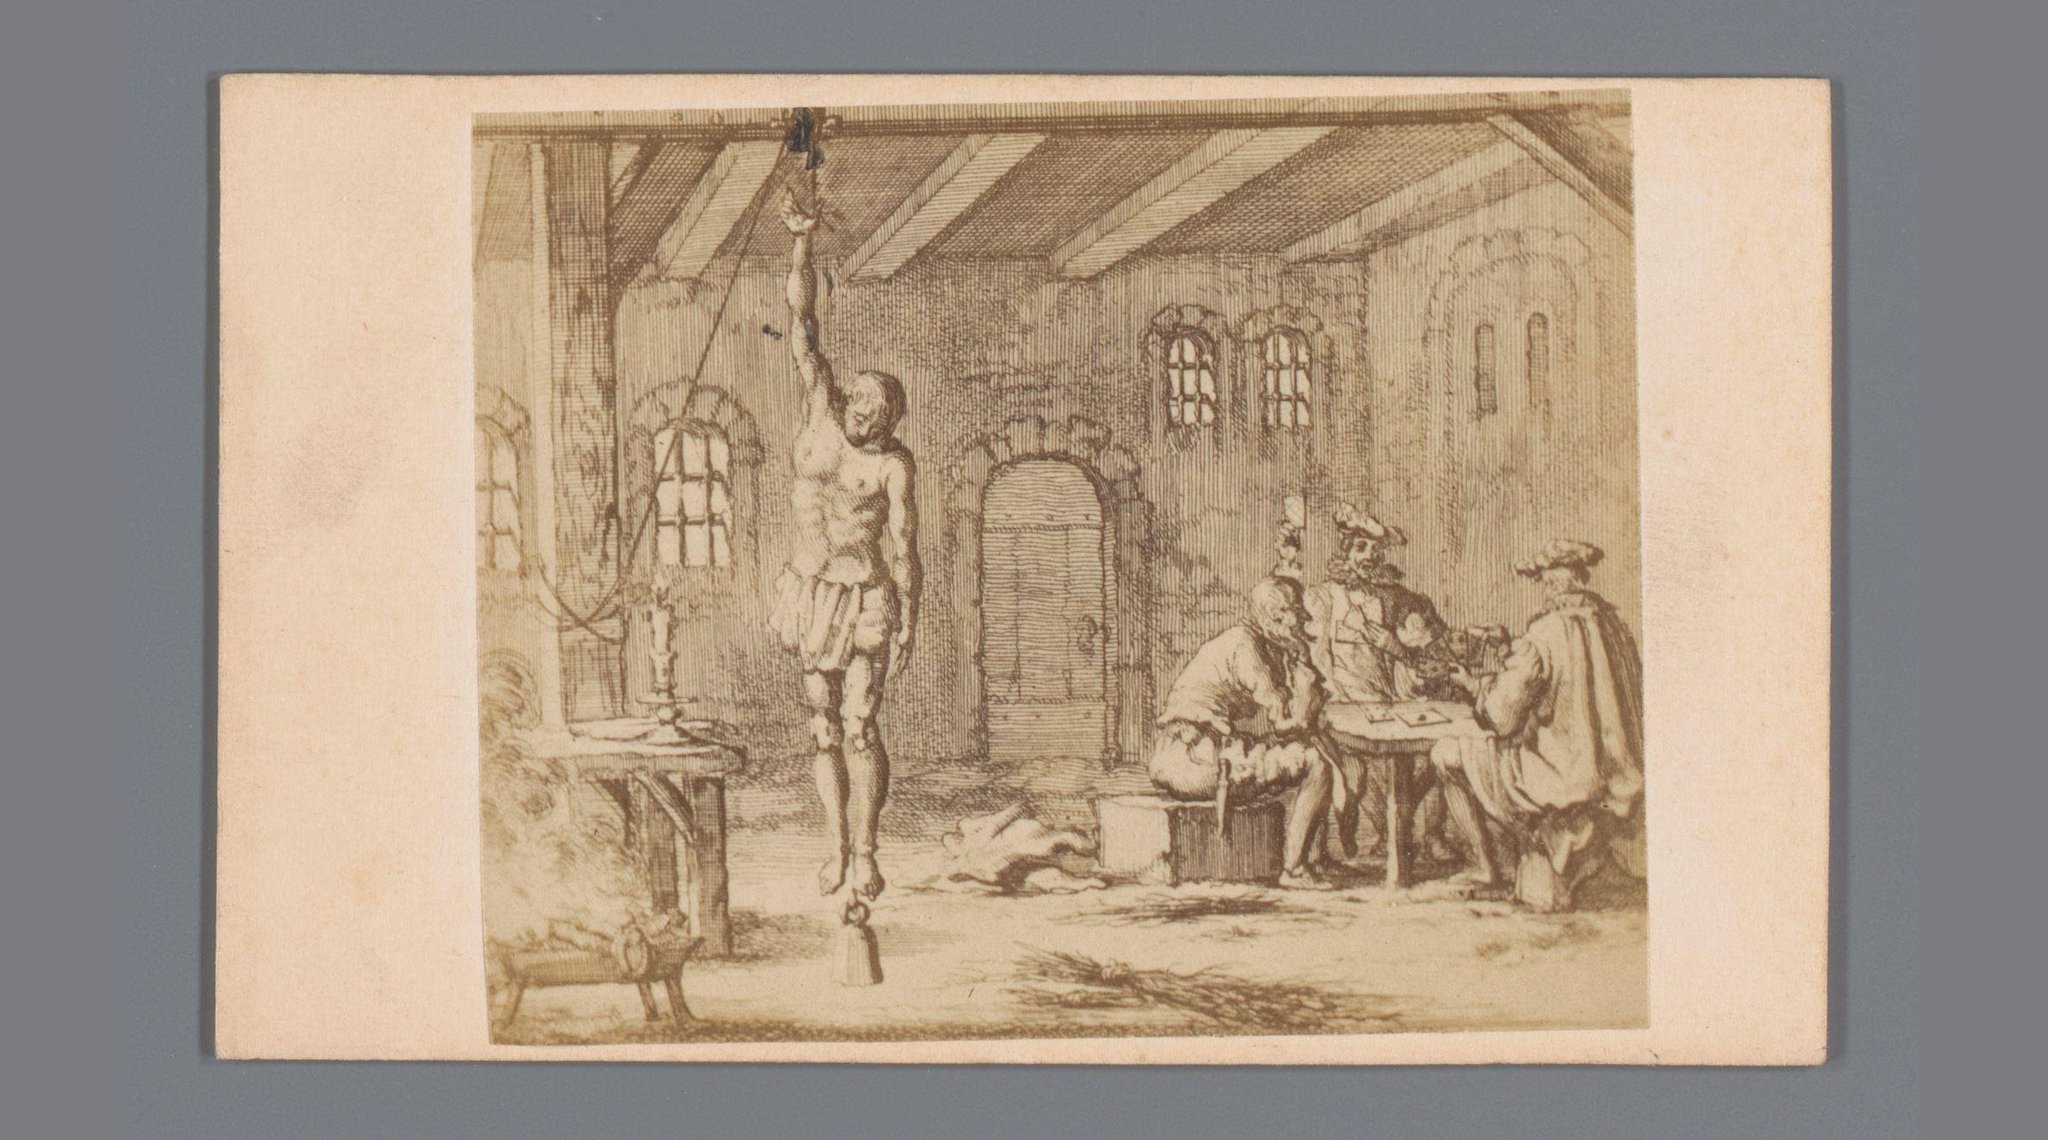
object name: photograph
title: Fotoreproductie van een prent van Geleyn Cornelisse, gepijnigd in de gevangenis van Breda, door Jan Luyken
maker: Anonymous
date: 1855-1885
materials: cardboard, paper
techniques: albumen print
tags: execution of heretic, e.g. by burning at the stake, 'auto-da-fé', torture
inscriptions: inscription: ‘Geleyn Cornelisse, een schoenmaker van Middelharnis (...) levend verbrand. Dit geschiedde in Augustus 1572.’, number: ‘No. 10.’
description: Naar een prent van Jan Luyken uit 1683-1685. Vgl. RP-P-OB-78.450.